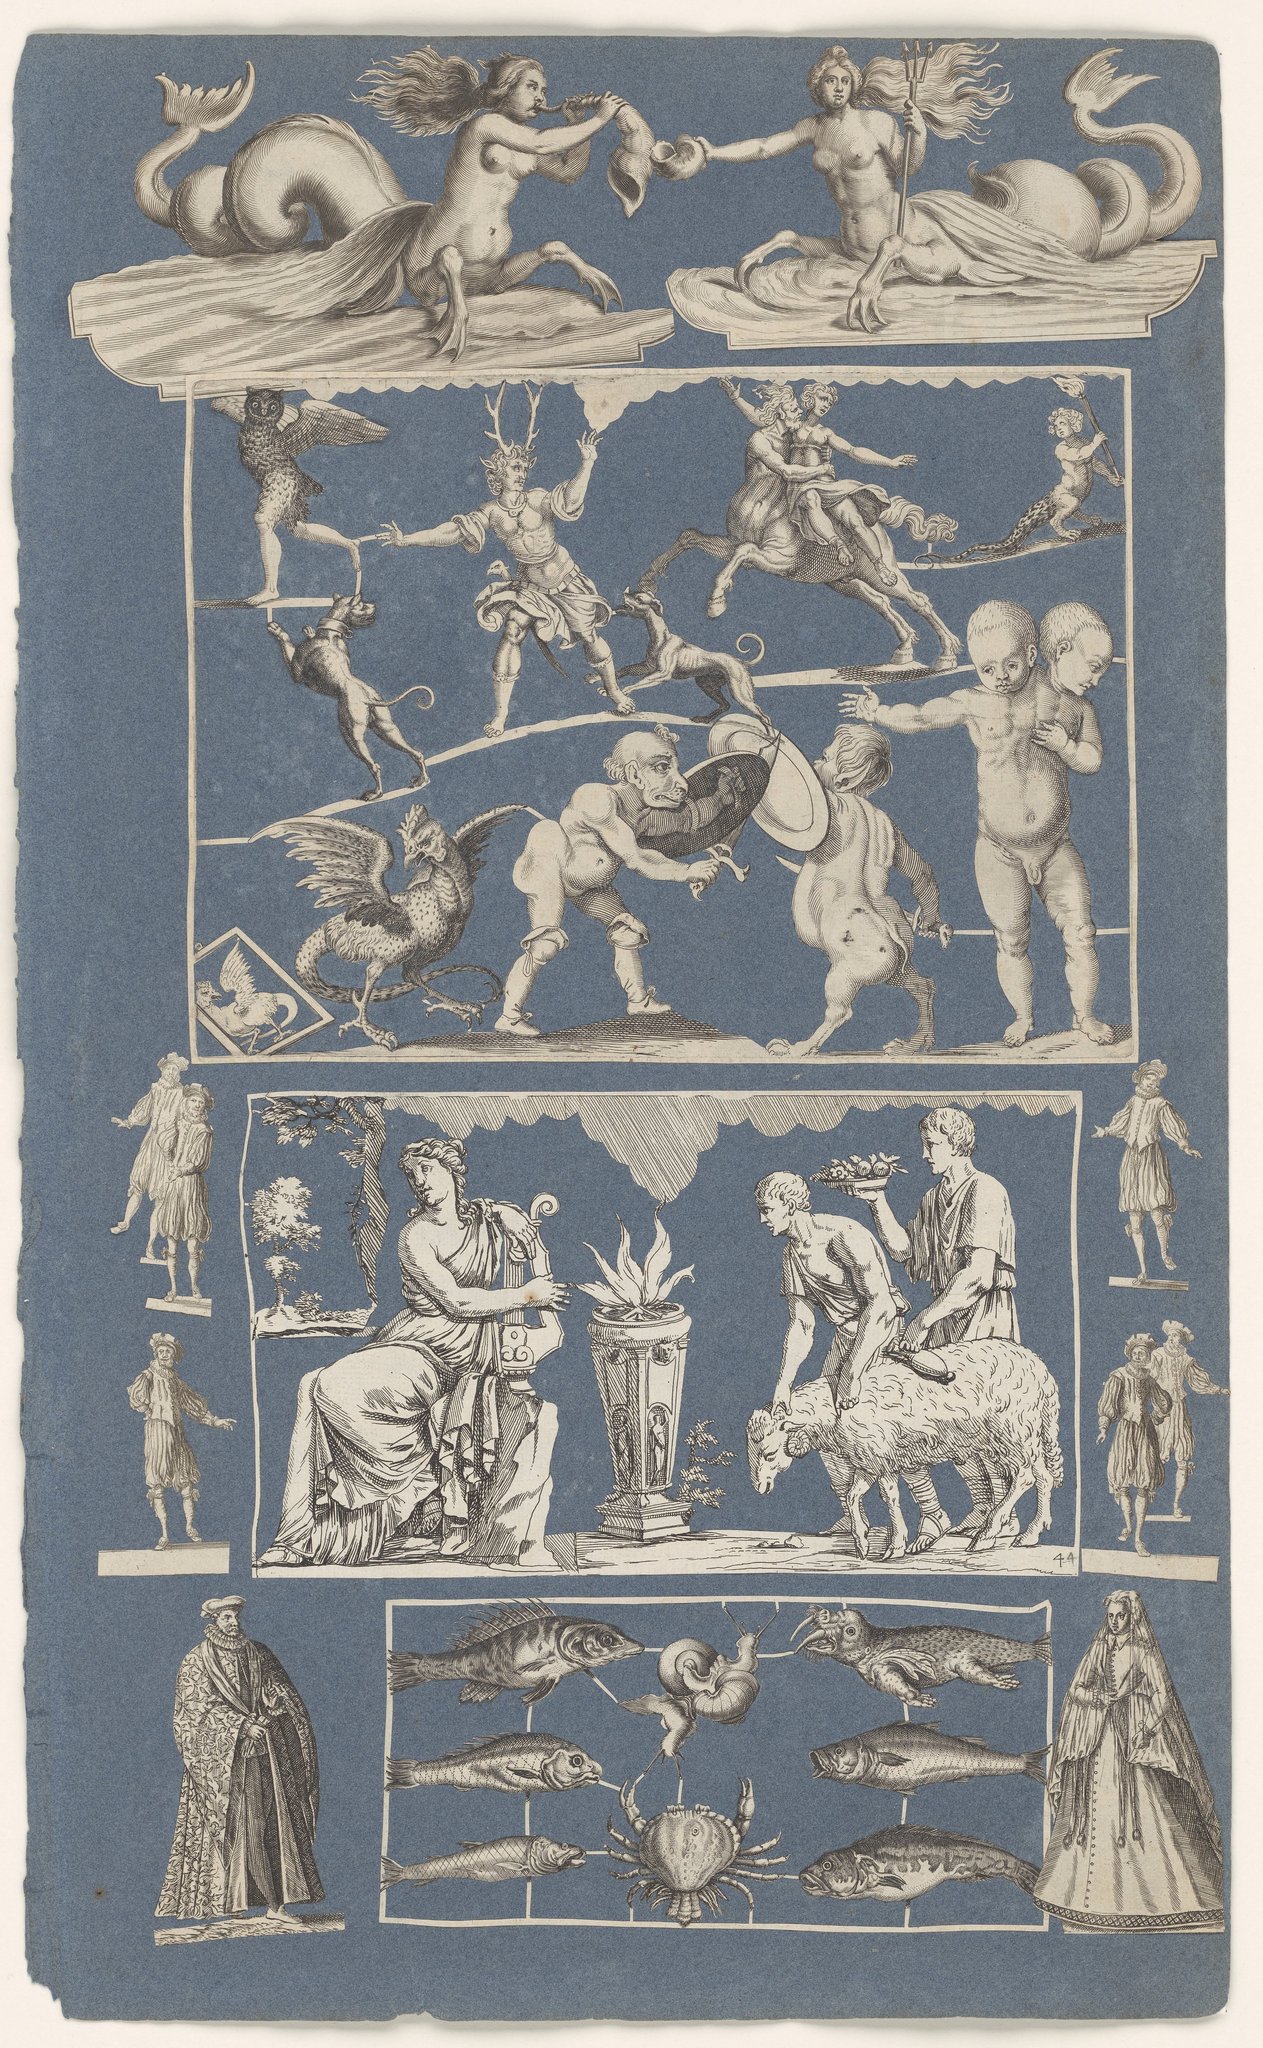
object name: album leaf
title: Wonderen der natuur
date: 1690-1720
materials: paper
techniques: engraving, snipping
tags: nereids, daughters of nereus; sea-nymphs, centaurs (in general) - love-affairs, monsters of mixed human and animal shape; 'mostri' (ripa), looking in the mirror; contemplation of own beauty, siamese twins, basilisk (cock with posterior of snake), dog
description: Blauw albumblad beplakt met uitgeknipte prenten van verschillende prentmakers met mythologische wezens, fabeldieren, echte dieren en mensen. Bovenaan twee Nereïden. Daaronder een studieblad met rariteiten waaronder fabeldieren, een soldaat met horens, een basilisk die zijn spiegelbeeld bekijkt, vechtende monsters en een aan elkaar vergroeide tweeling. Daaronder de voorstelling van een vrouw met lier bij een offerzuil en twee mannen die een ram en fruit brengen. Onderaan vissen, een krab, een slak en een zeehond. Links- en rechtsonder staande menselijke figuren.